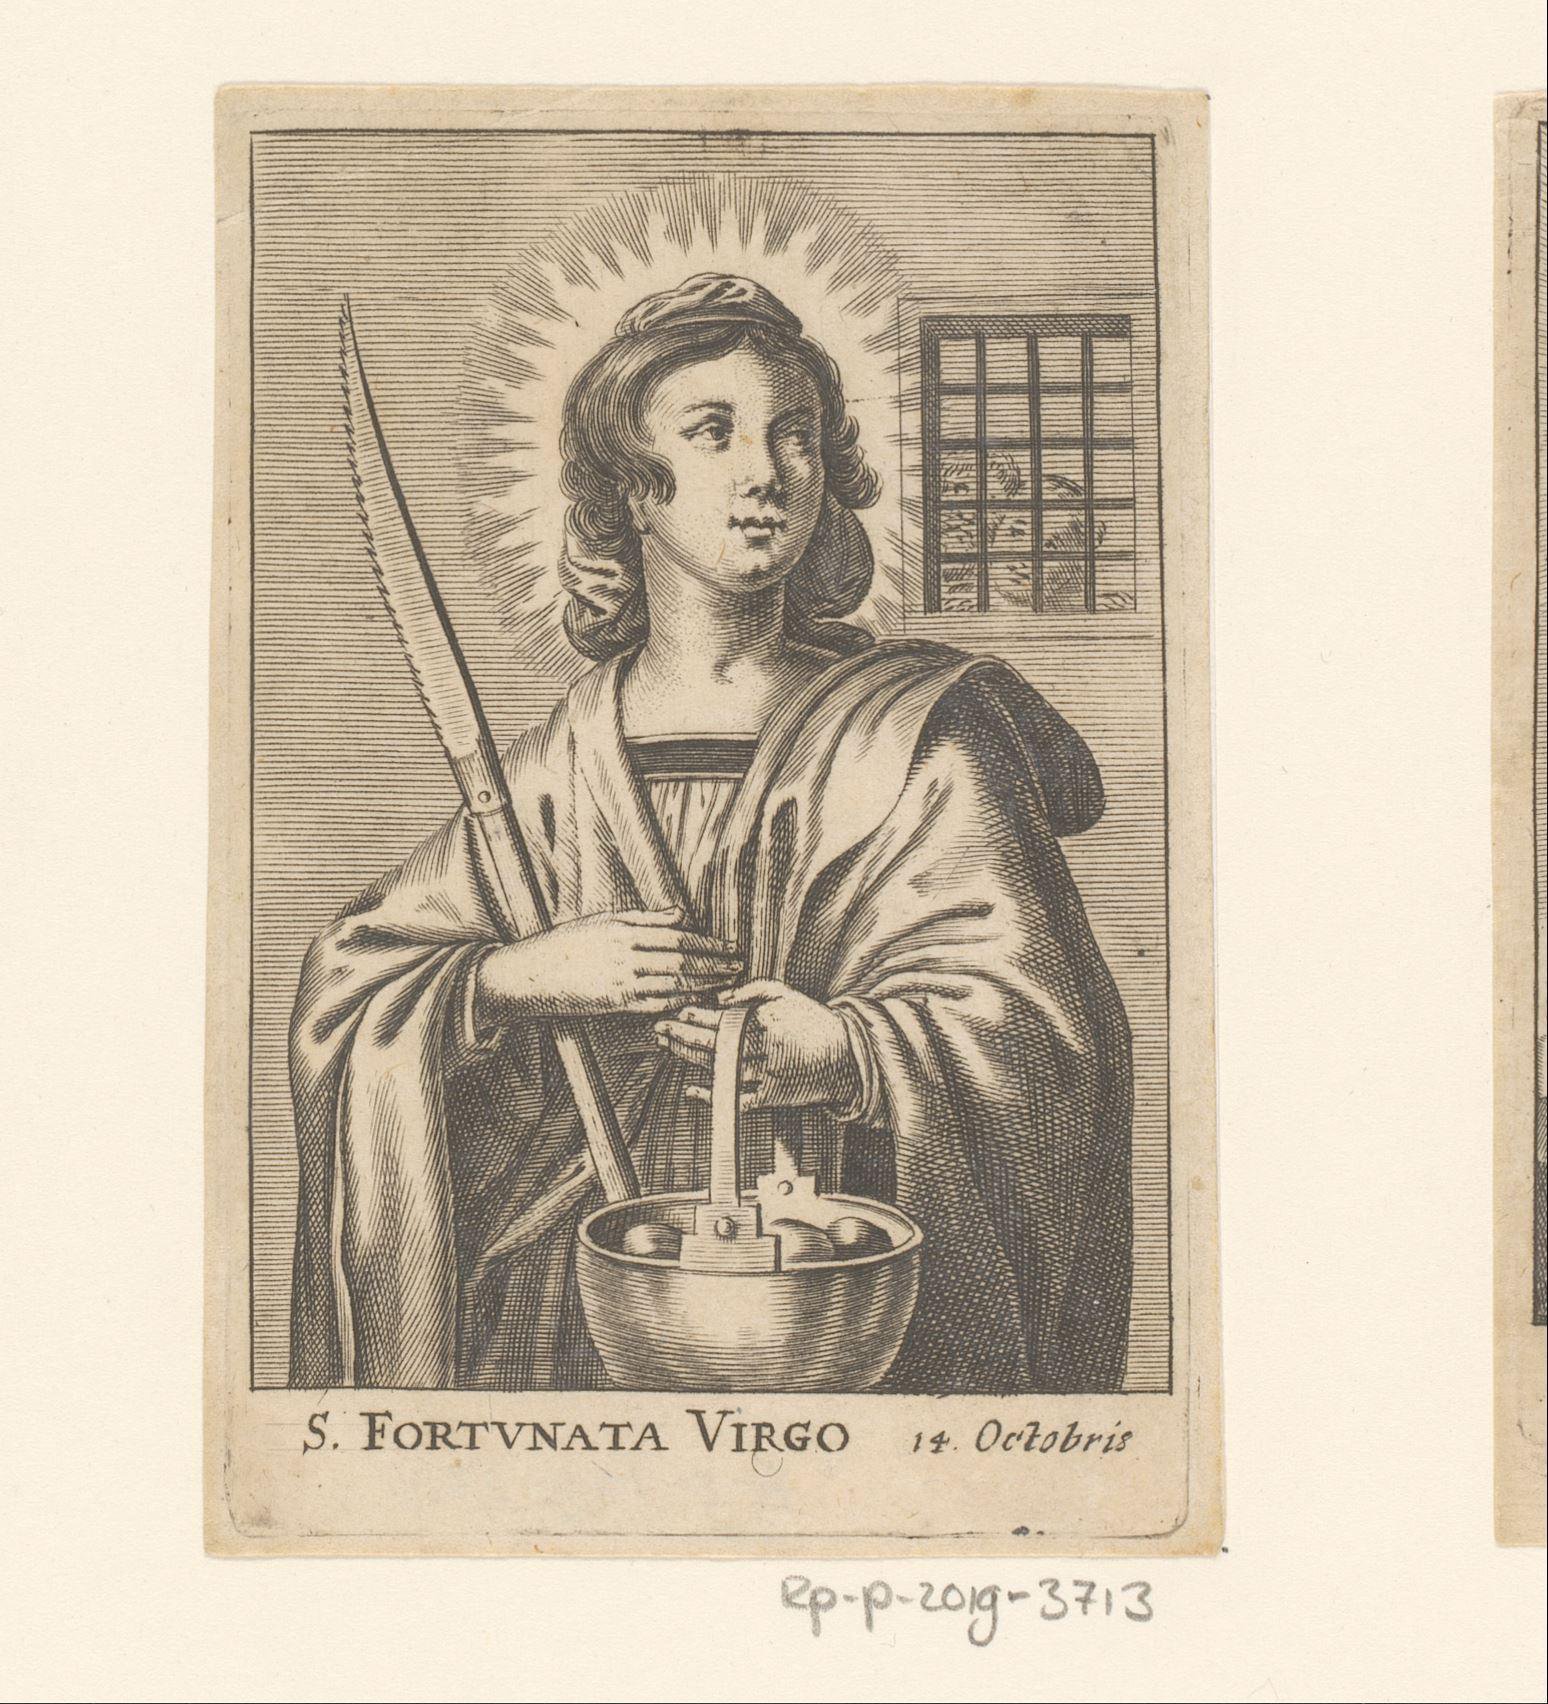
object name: print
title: S. Fortunata Virgo 14 Octobris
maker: Anonymous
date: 1600-1699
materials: paper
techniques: engraving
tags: female saints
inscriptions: collector's mark: Lugt 2228